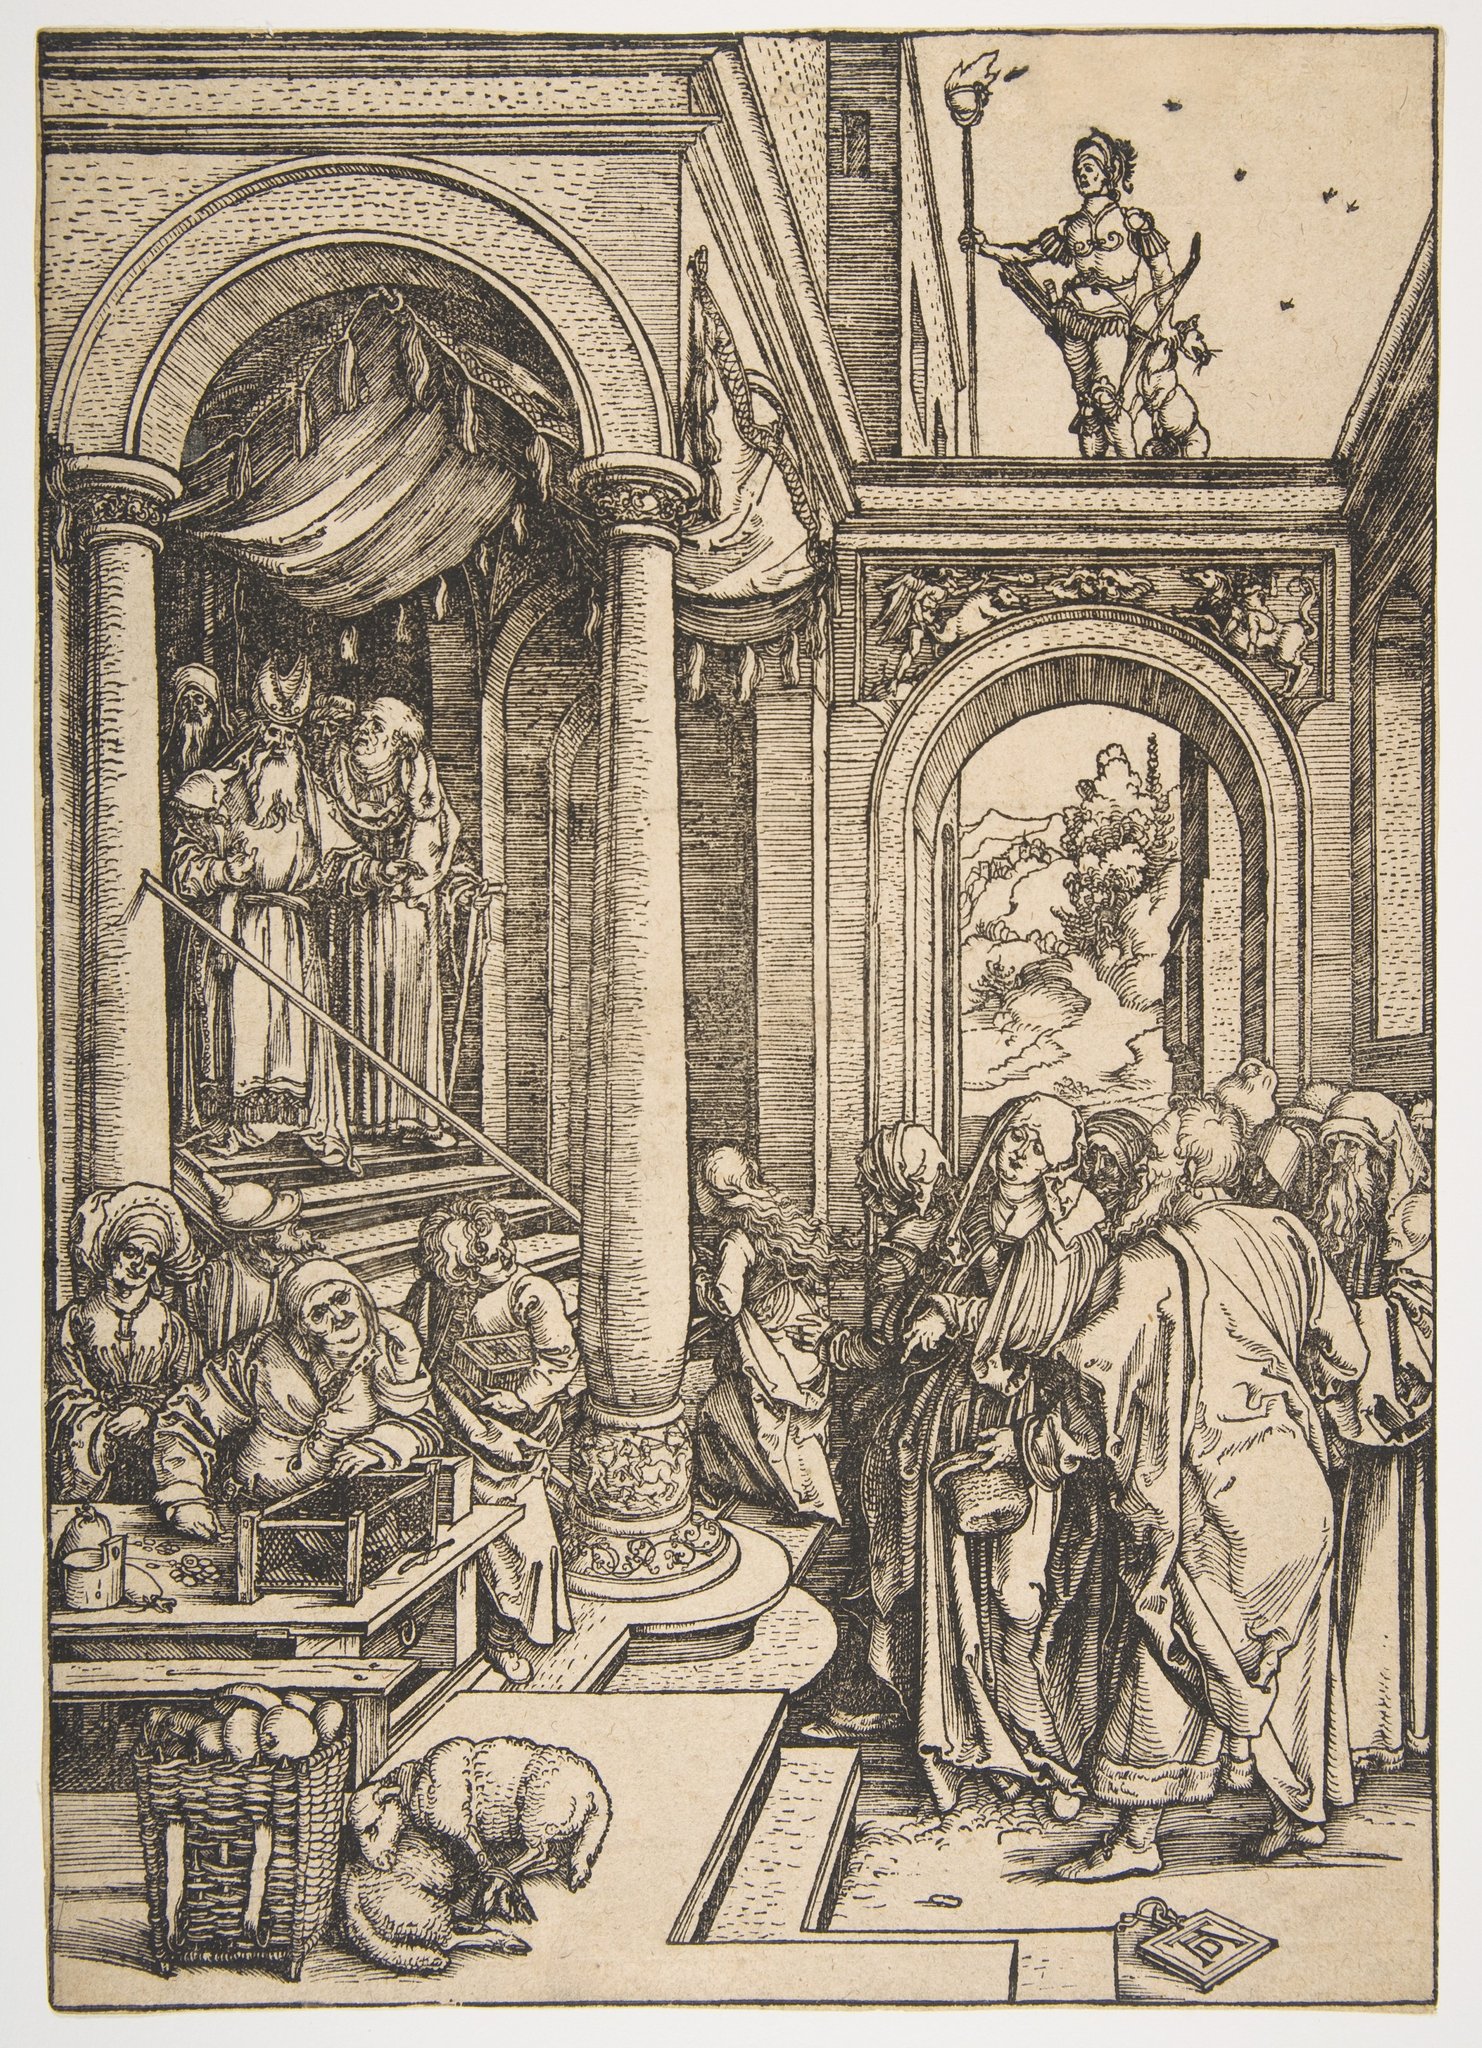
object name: print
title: The Presentation of The Virgin in the Temple, from "The Life of The Virgin"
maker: albrecht dürer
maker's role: artist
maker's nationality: german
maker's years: 1471-1528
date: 1503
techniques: woodcut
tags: temples,sheep,virgin mary,saints,crowd